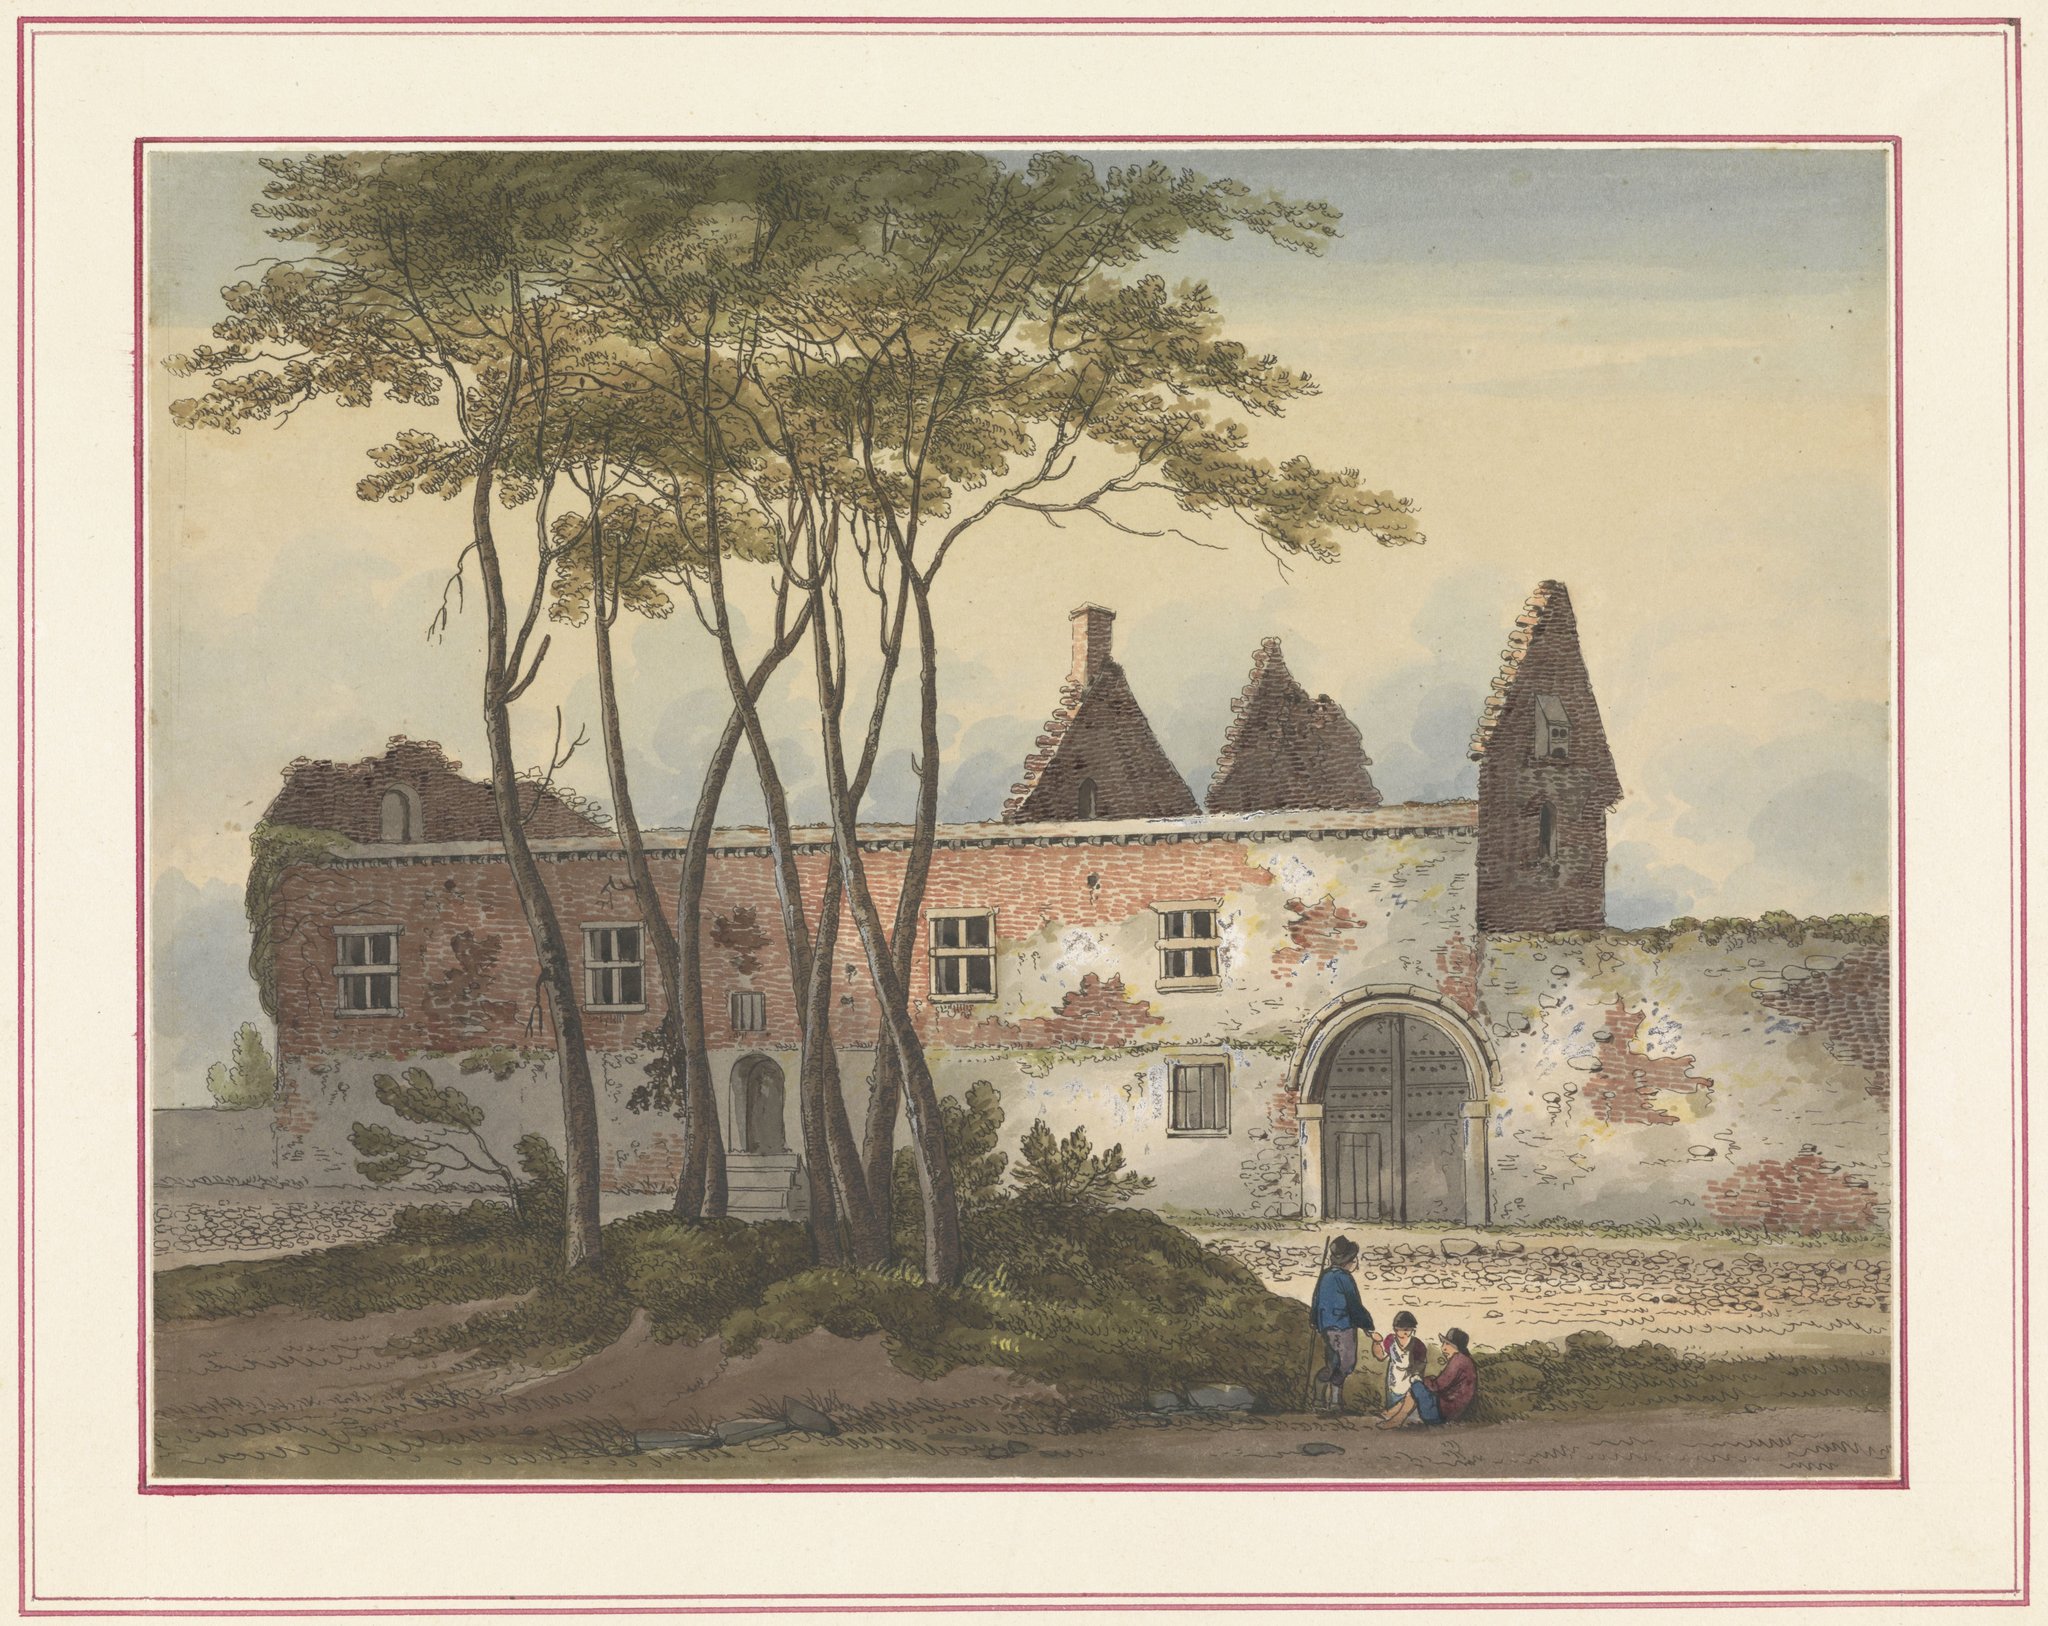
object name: print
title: Zeven platen van Waterloo en omgeving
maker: Anonymous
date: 1815-1825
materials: paper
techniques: etching, hand coloring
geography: low countries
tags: devastated, ruined place or city (~ warfare), farm (building), waterloo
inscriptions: collector's mark: Lugt 2228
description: De ruïnes van de hoeve en kasteel van Hougoumont. Plaats van zware gevechten tijdens de slag bij Waterloo. Onderdeel van een serie van zeven platen met gezichten uit ca. 1820 van de omgeving waar de slag bij Waterloo plaatsvond op 18 juni 1815.